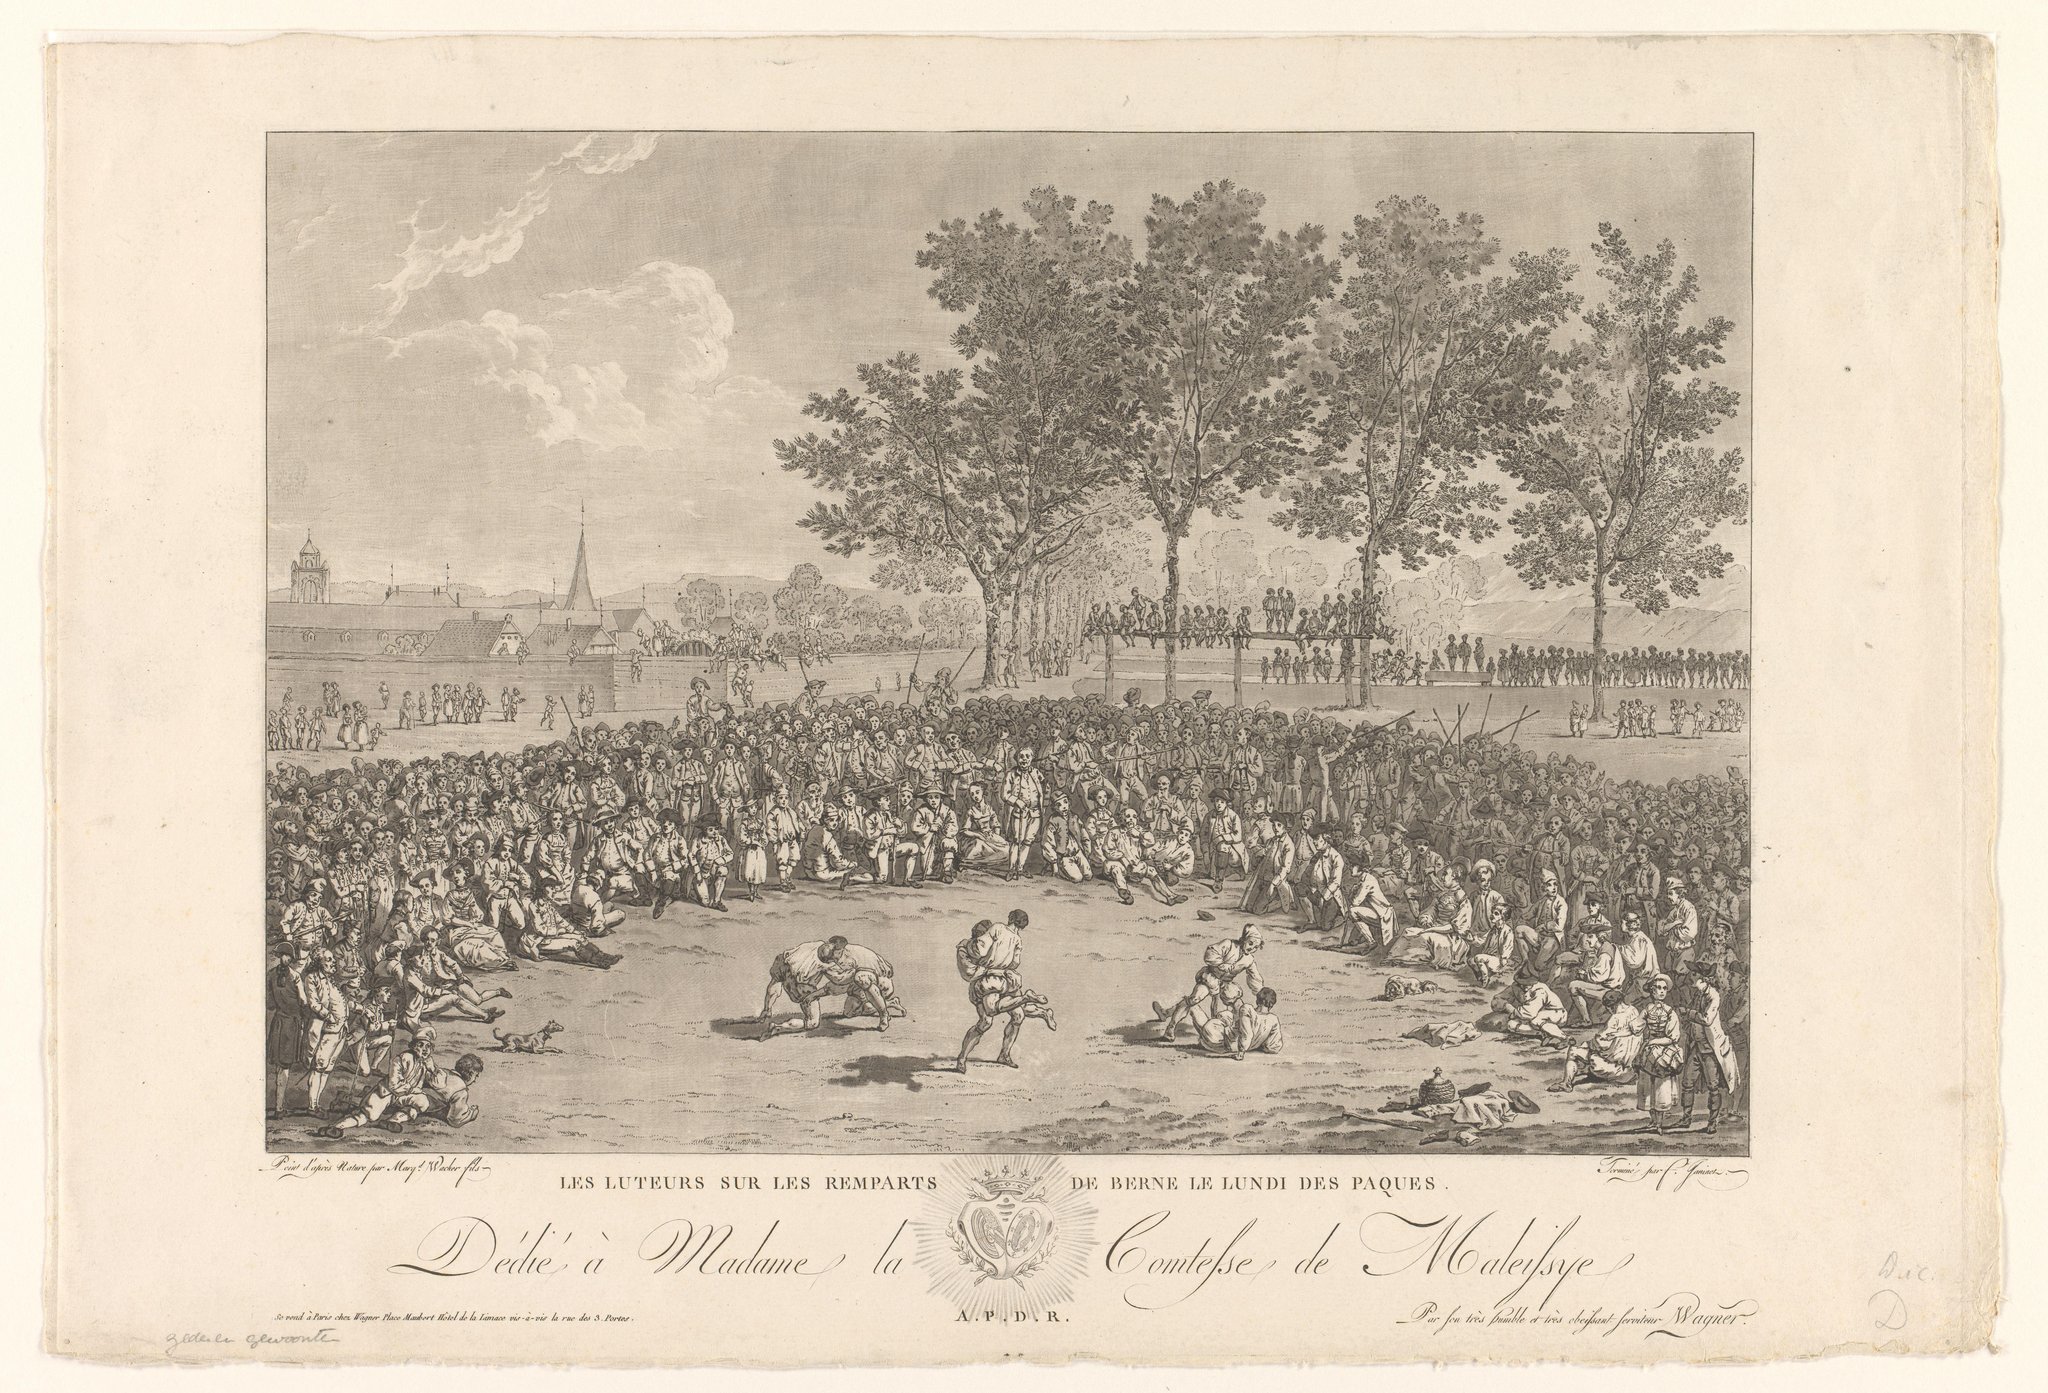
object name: print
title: Les Luteurs sur les remparts de Berne le Lundi des Paques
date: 1775-1777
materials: paper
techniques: aquatint, etching, rocker stamped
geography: paris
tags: wrestling (sport), outskirts of city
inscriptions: collector's mark: Lugt 2233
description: De prent is opgedragen aan 'Madame la Comtesse de Maleissye', mogelijk Elisabeth-Marie de Paignon.